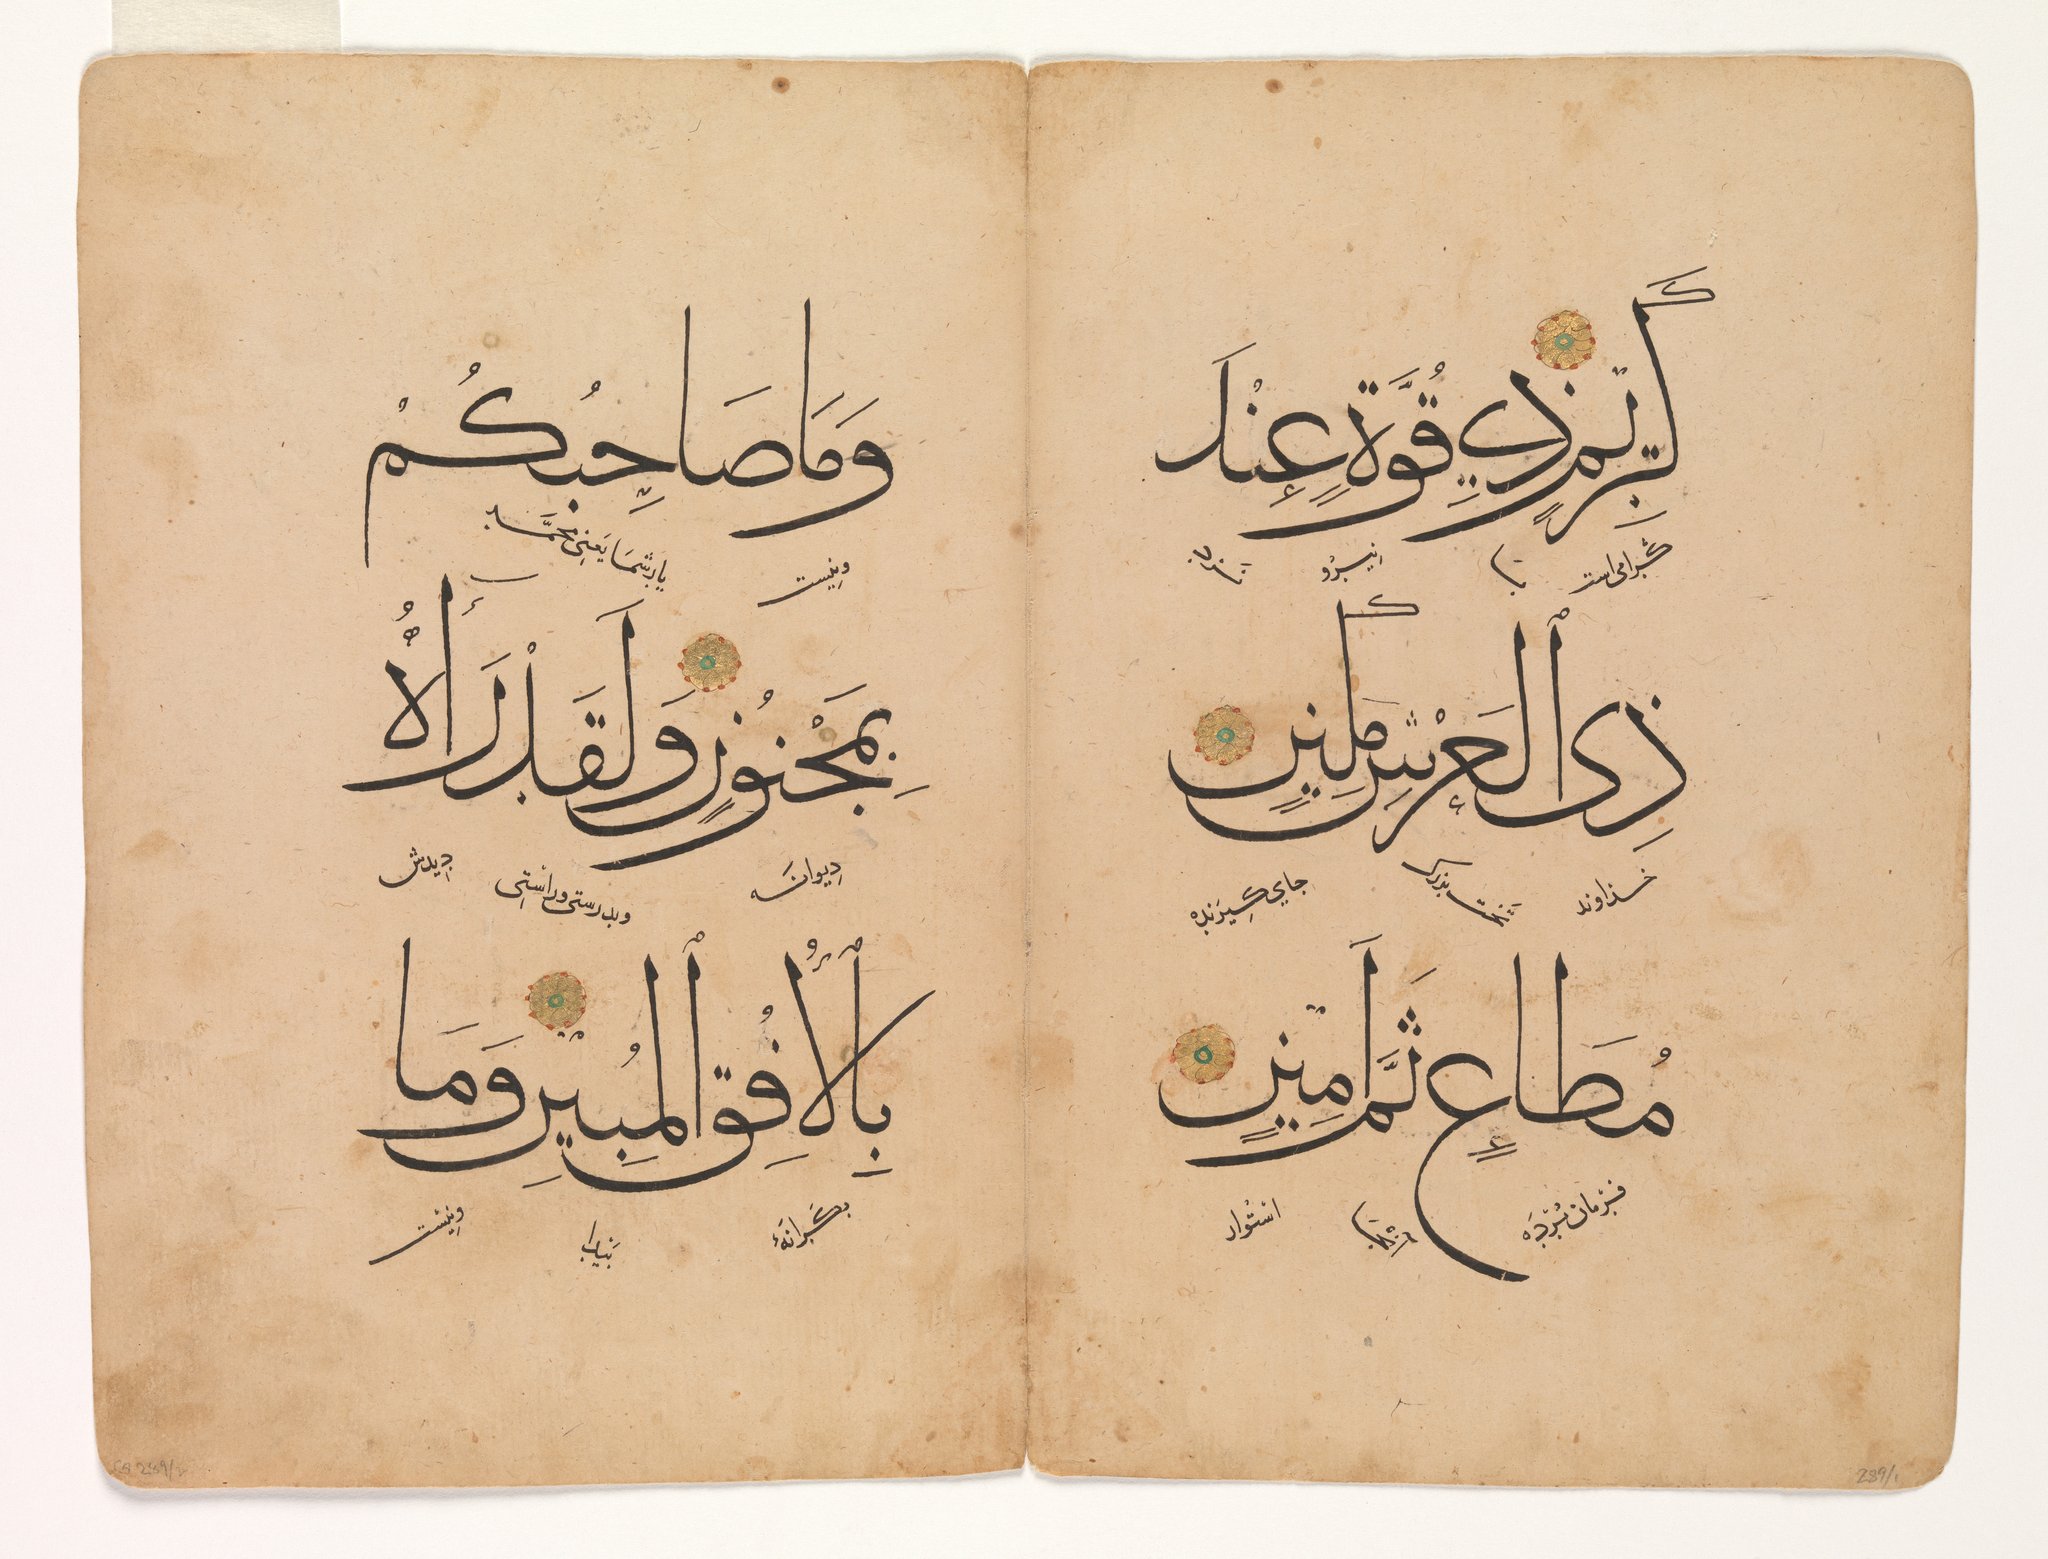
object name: bifolium from a non illustrated manuscript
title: Bifolium from a Qur'an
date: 1301-1400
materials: gold, ink, paper, watercolor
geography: turkey or central asia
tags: qur'an,calligraphy